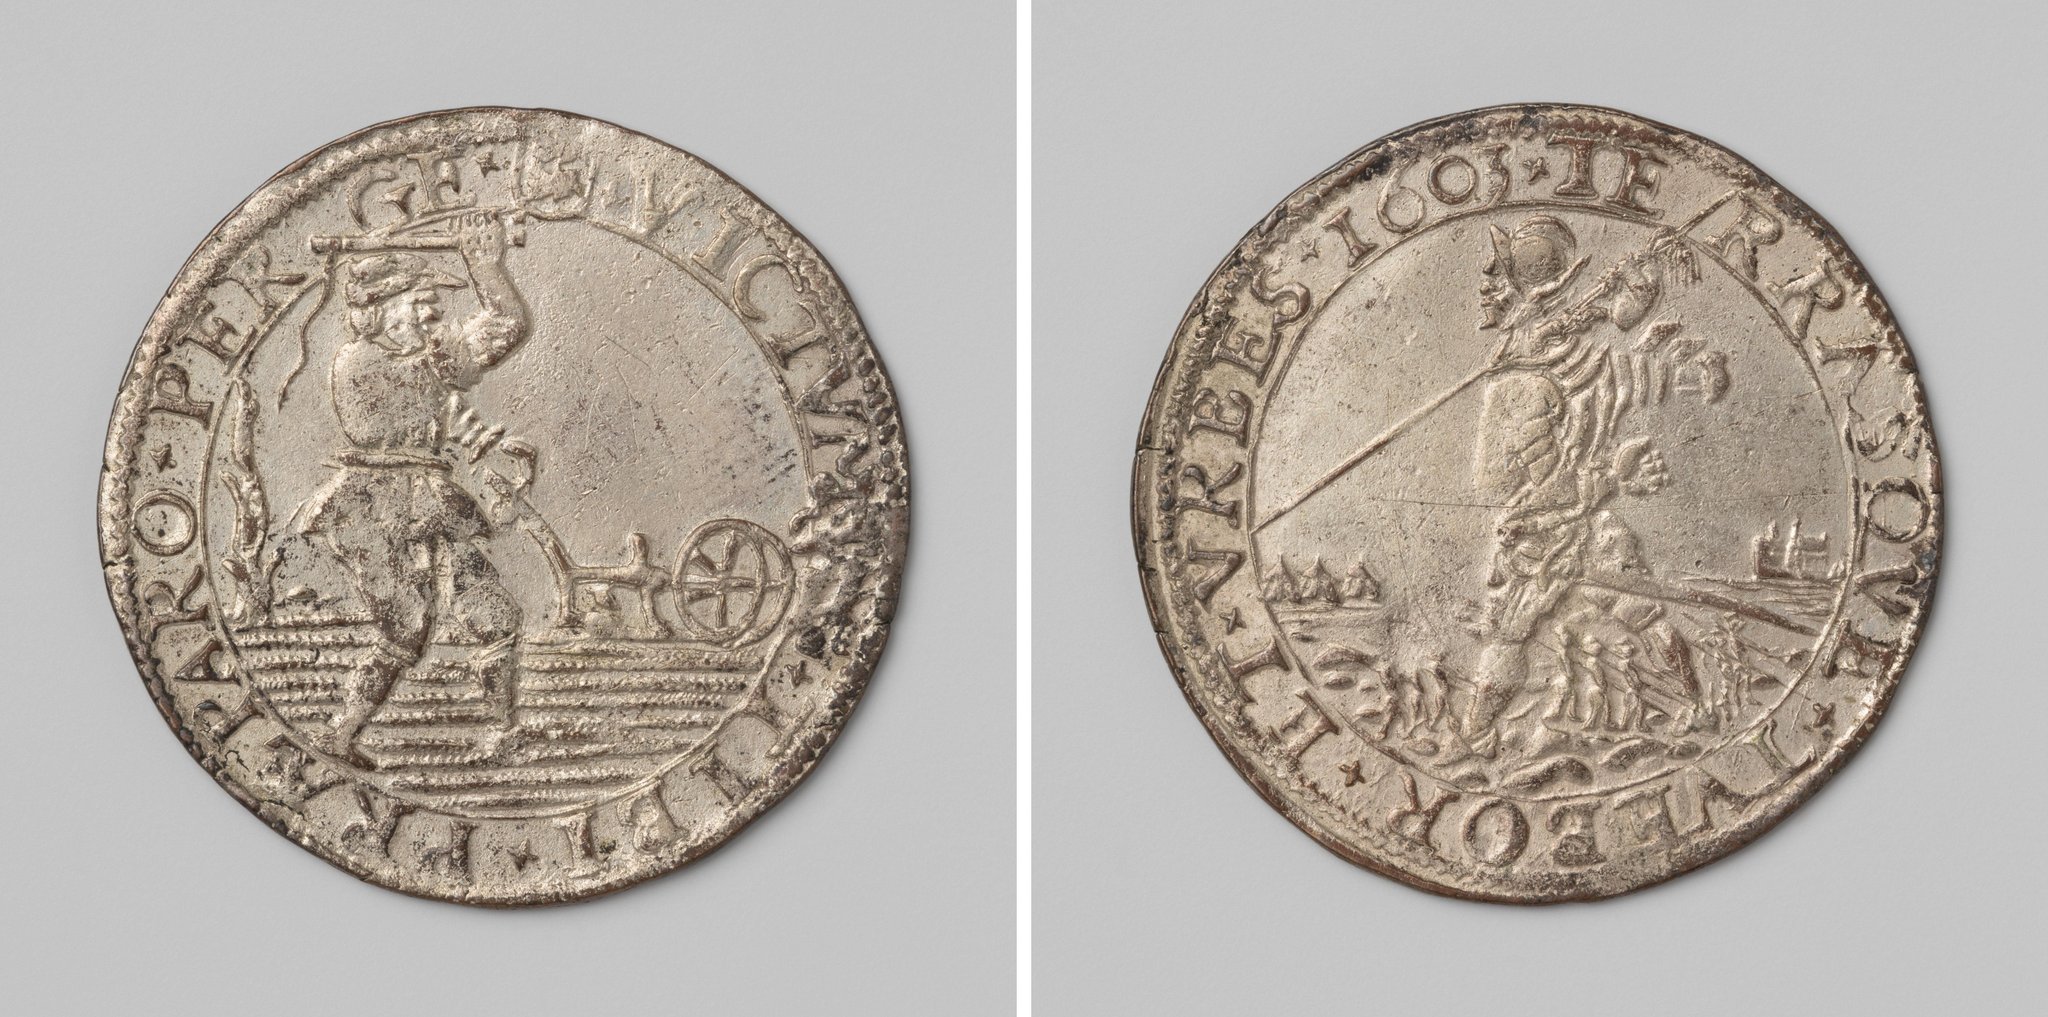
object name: jeton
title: De strijd tegen Spanje bekostigd uit de welvarende economie der Nederlanden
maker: Anonymous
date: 1603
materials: silver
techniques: striking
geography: west frisia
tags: staten van west-friesland, west-friesland, tachtigjarige oorlog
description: Zilveren penning. Voorzijde: ploegende boer met zweep boven hoofd binnen omschrift. Keerzijde: gehelmde soldaat met speer in hand; op achtergrond marcherende troepen binnen omschrift